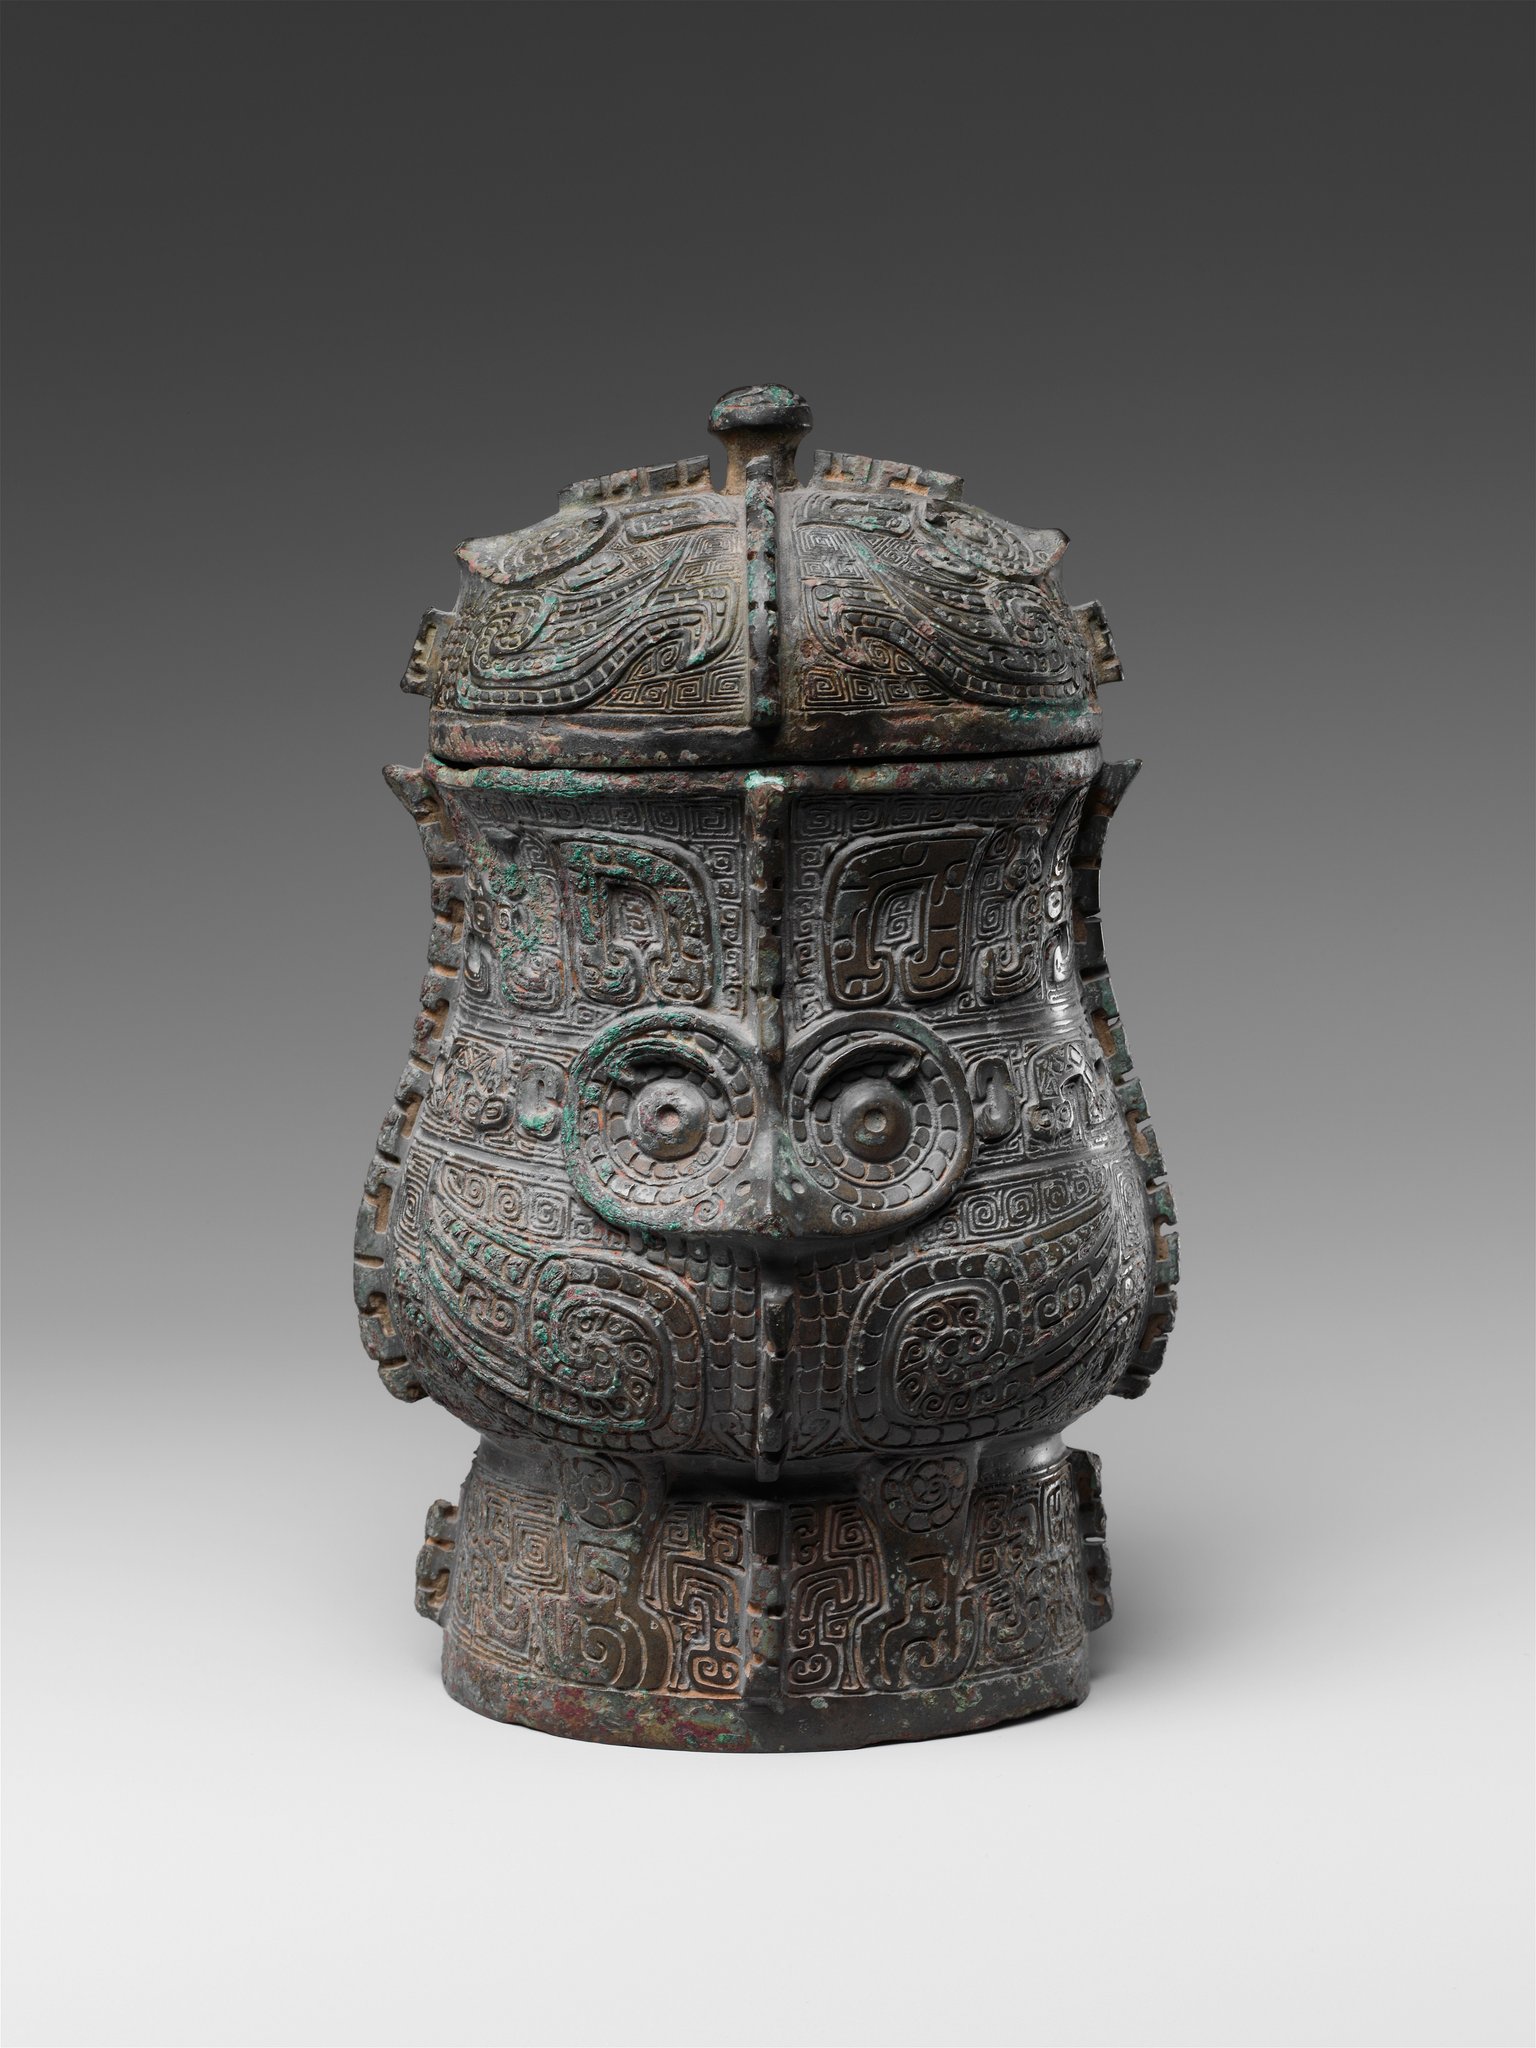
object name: wine cup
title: Wine cup (Zhi)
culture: chinese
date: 1300-1201 BCE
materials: bronze